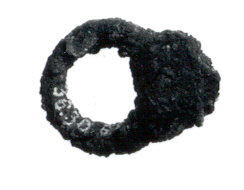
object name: ring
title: Finger ring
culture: sasanian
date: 201-700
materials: iron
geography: iran